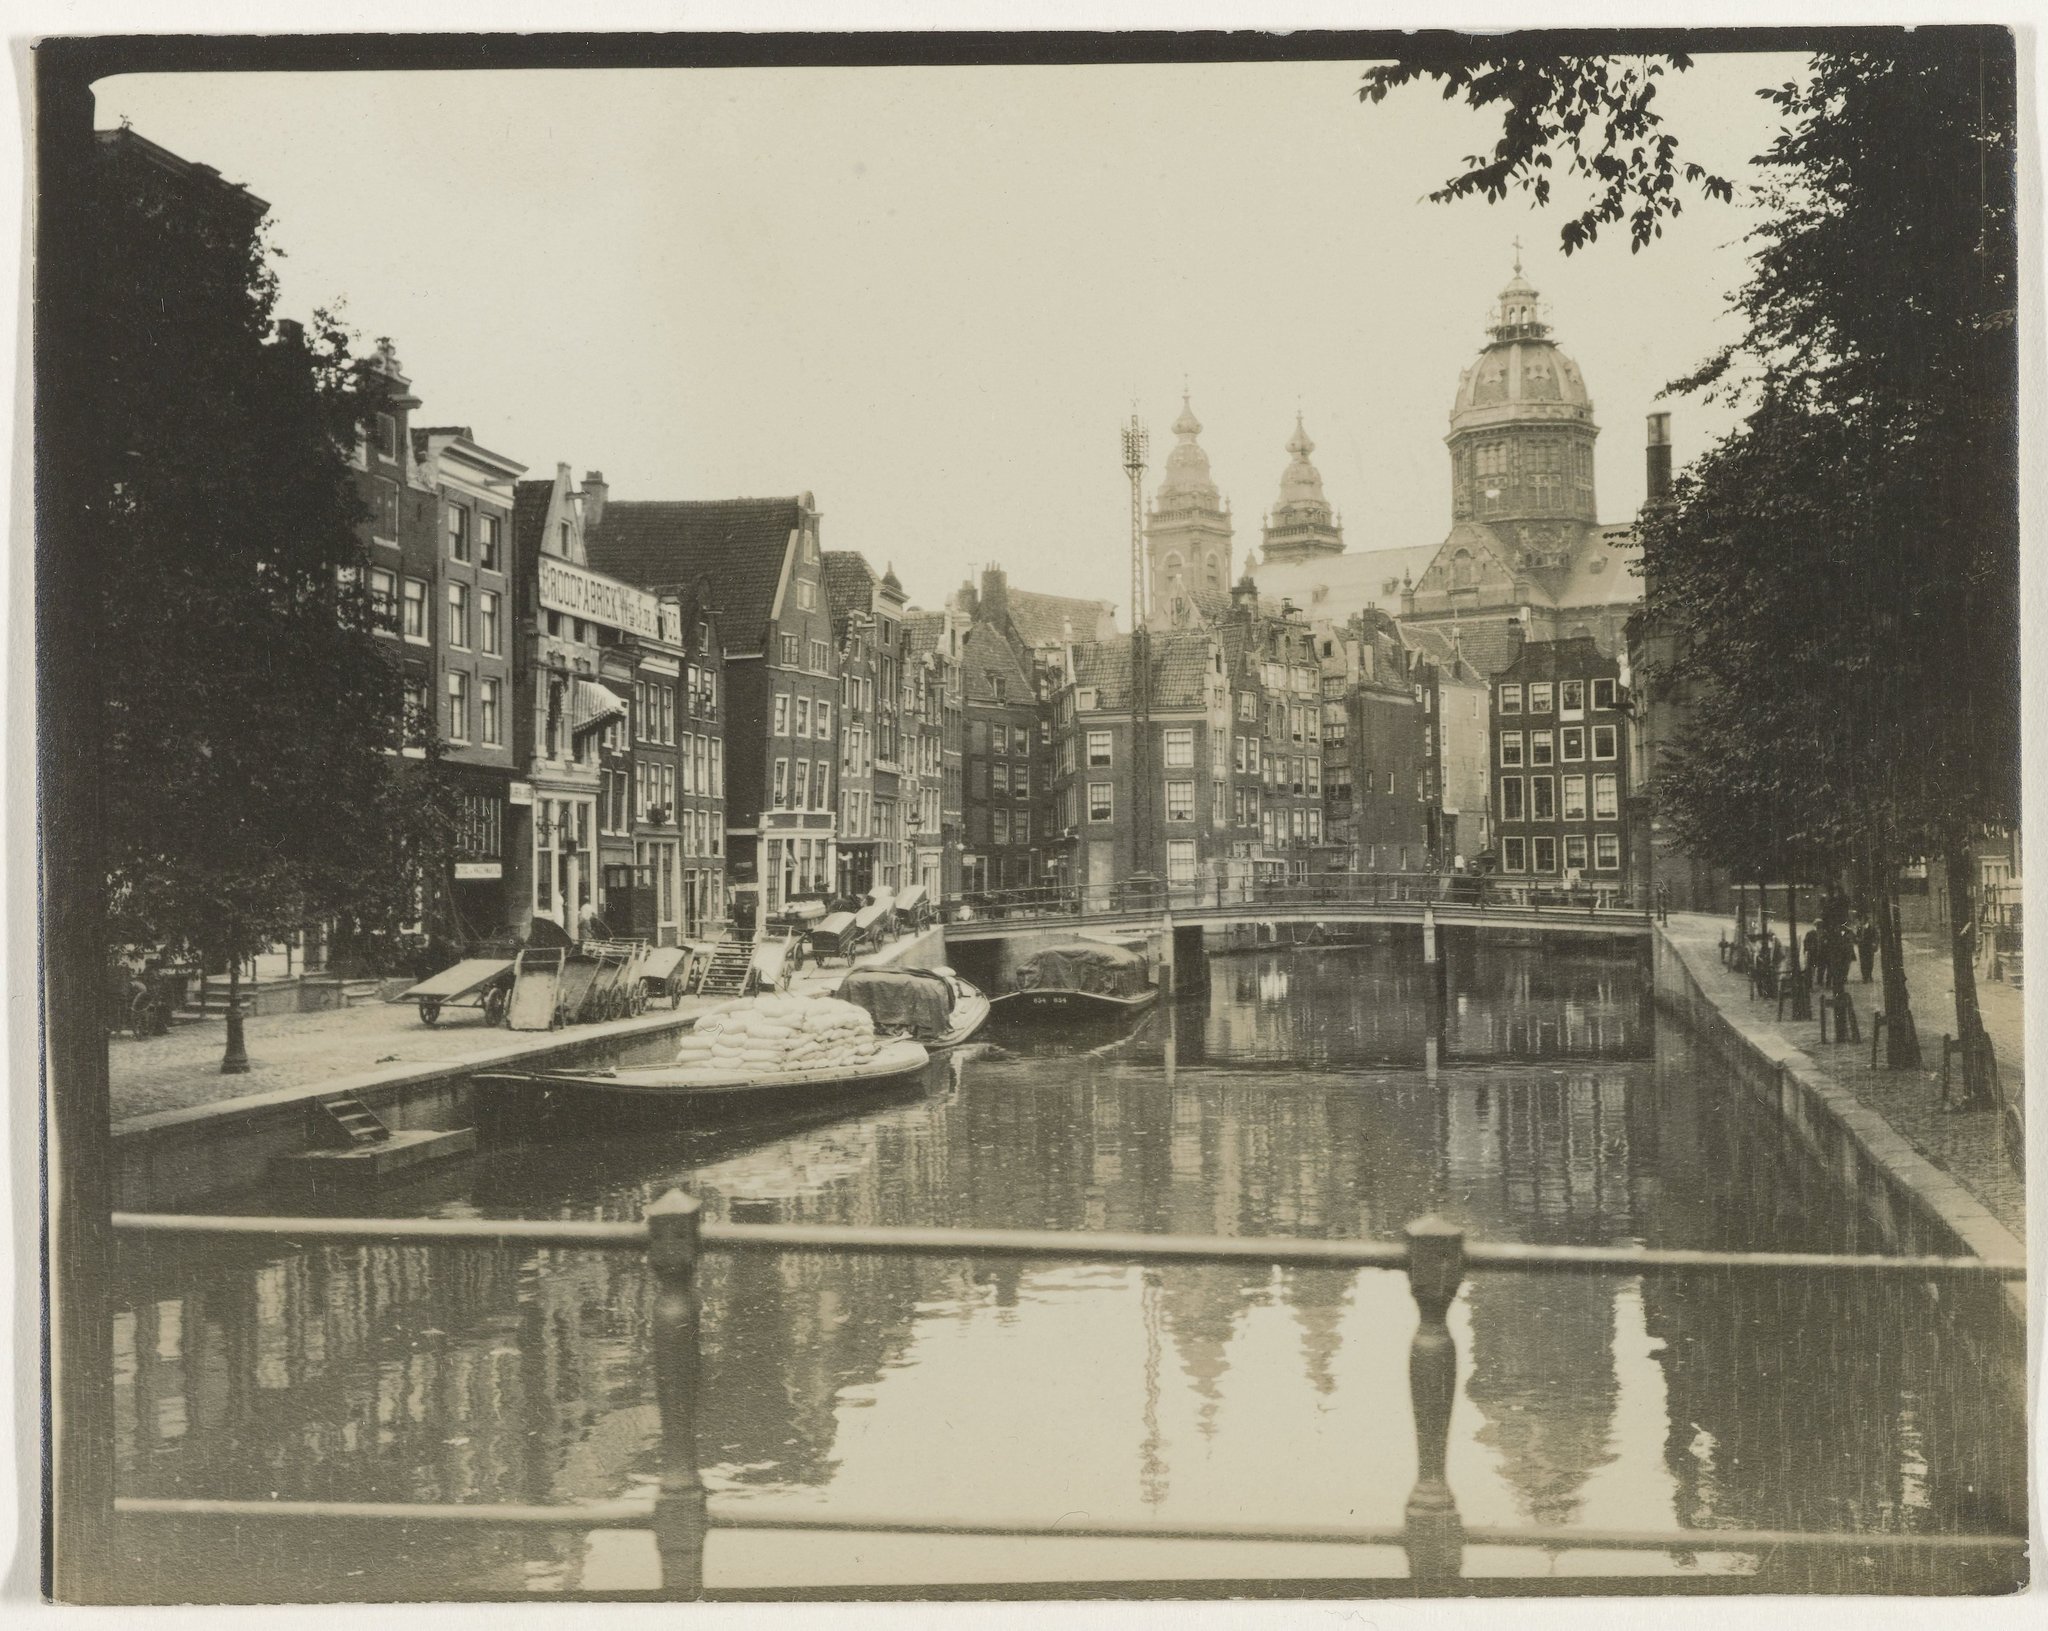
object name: photograph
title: Oudezijds Voorburgwal, Amsterdam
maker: Anonymous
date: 1900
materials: paper, photographic support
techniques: gelatin silver print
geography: amsterdam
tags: canals, waters (in city), amsterdam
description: Oudezijds Voorburgwal, Amsterdam, gezien naar de Sint Nicolaaskerk (gezien vanaf brug 207?).